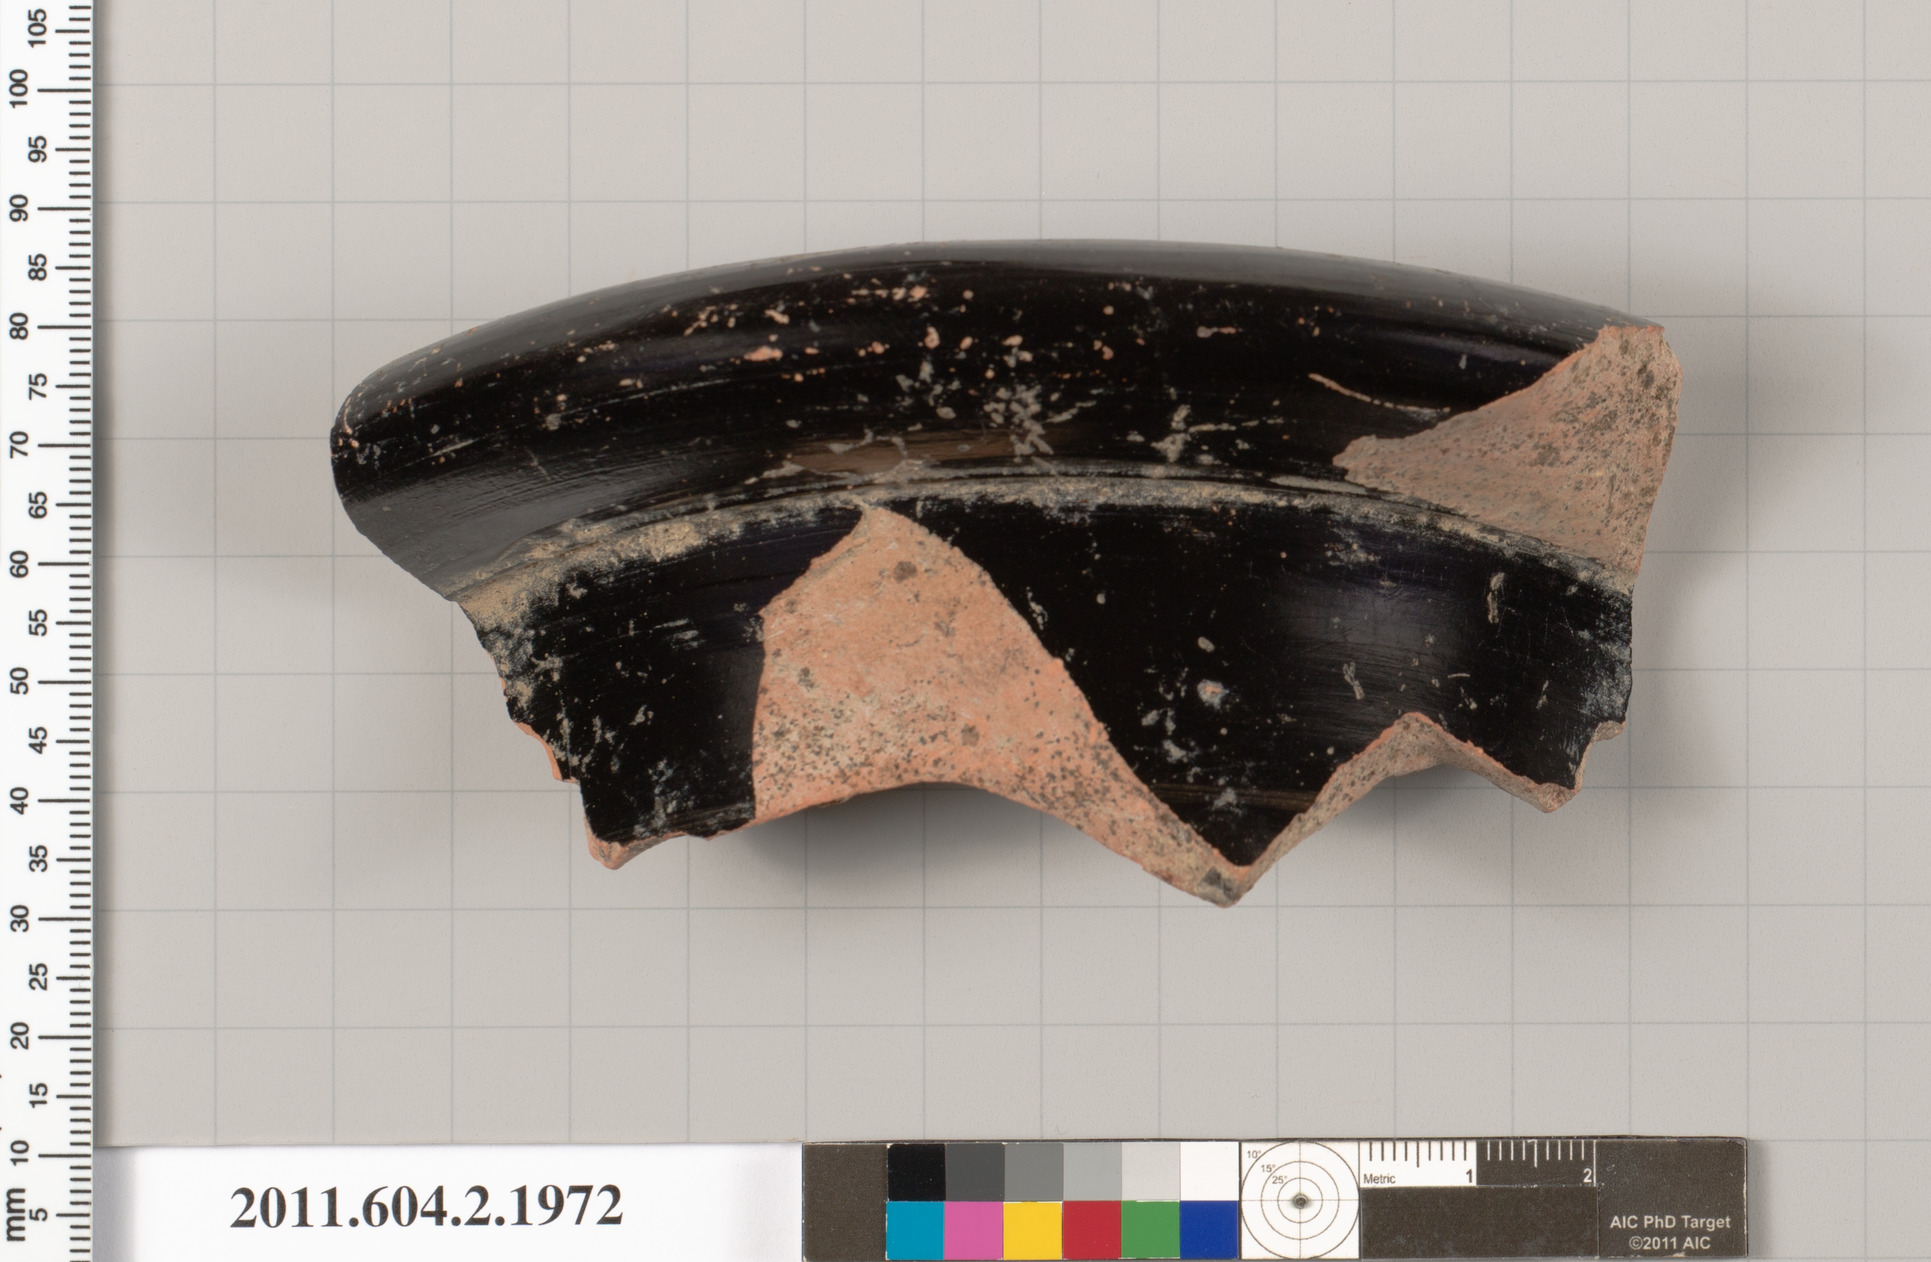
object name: pelike fragment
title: Terracotta fragment of a pelike (jar)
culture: greek, attic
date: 475-451 BCE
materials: terracotta